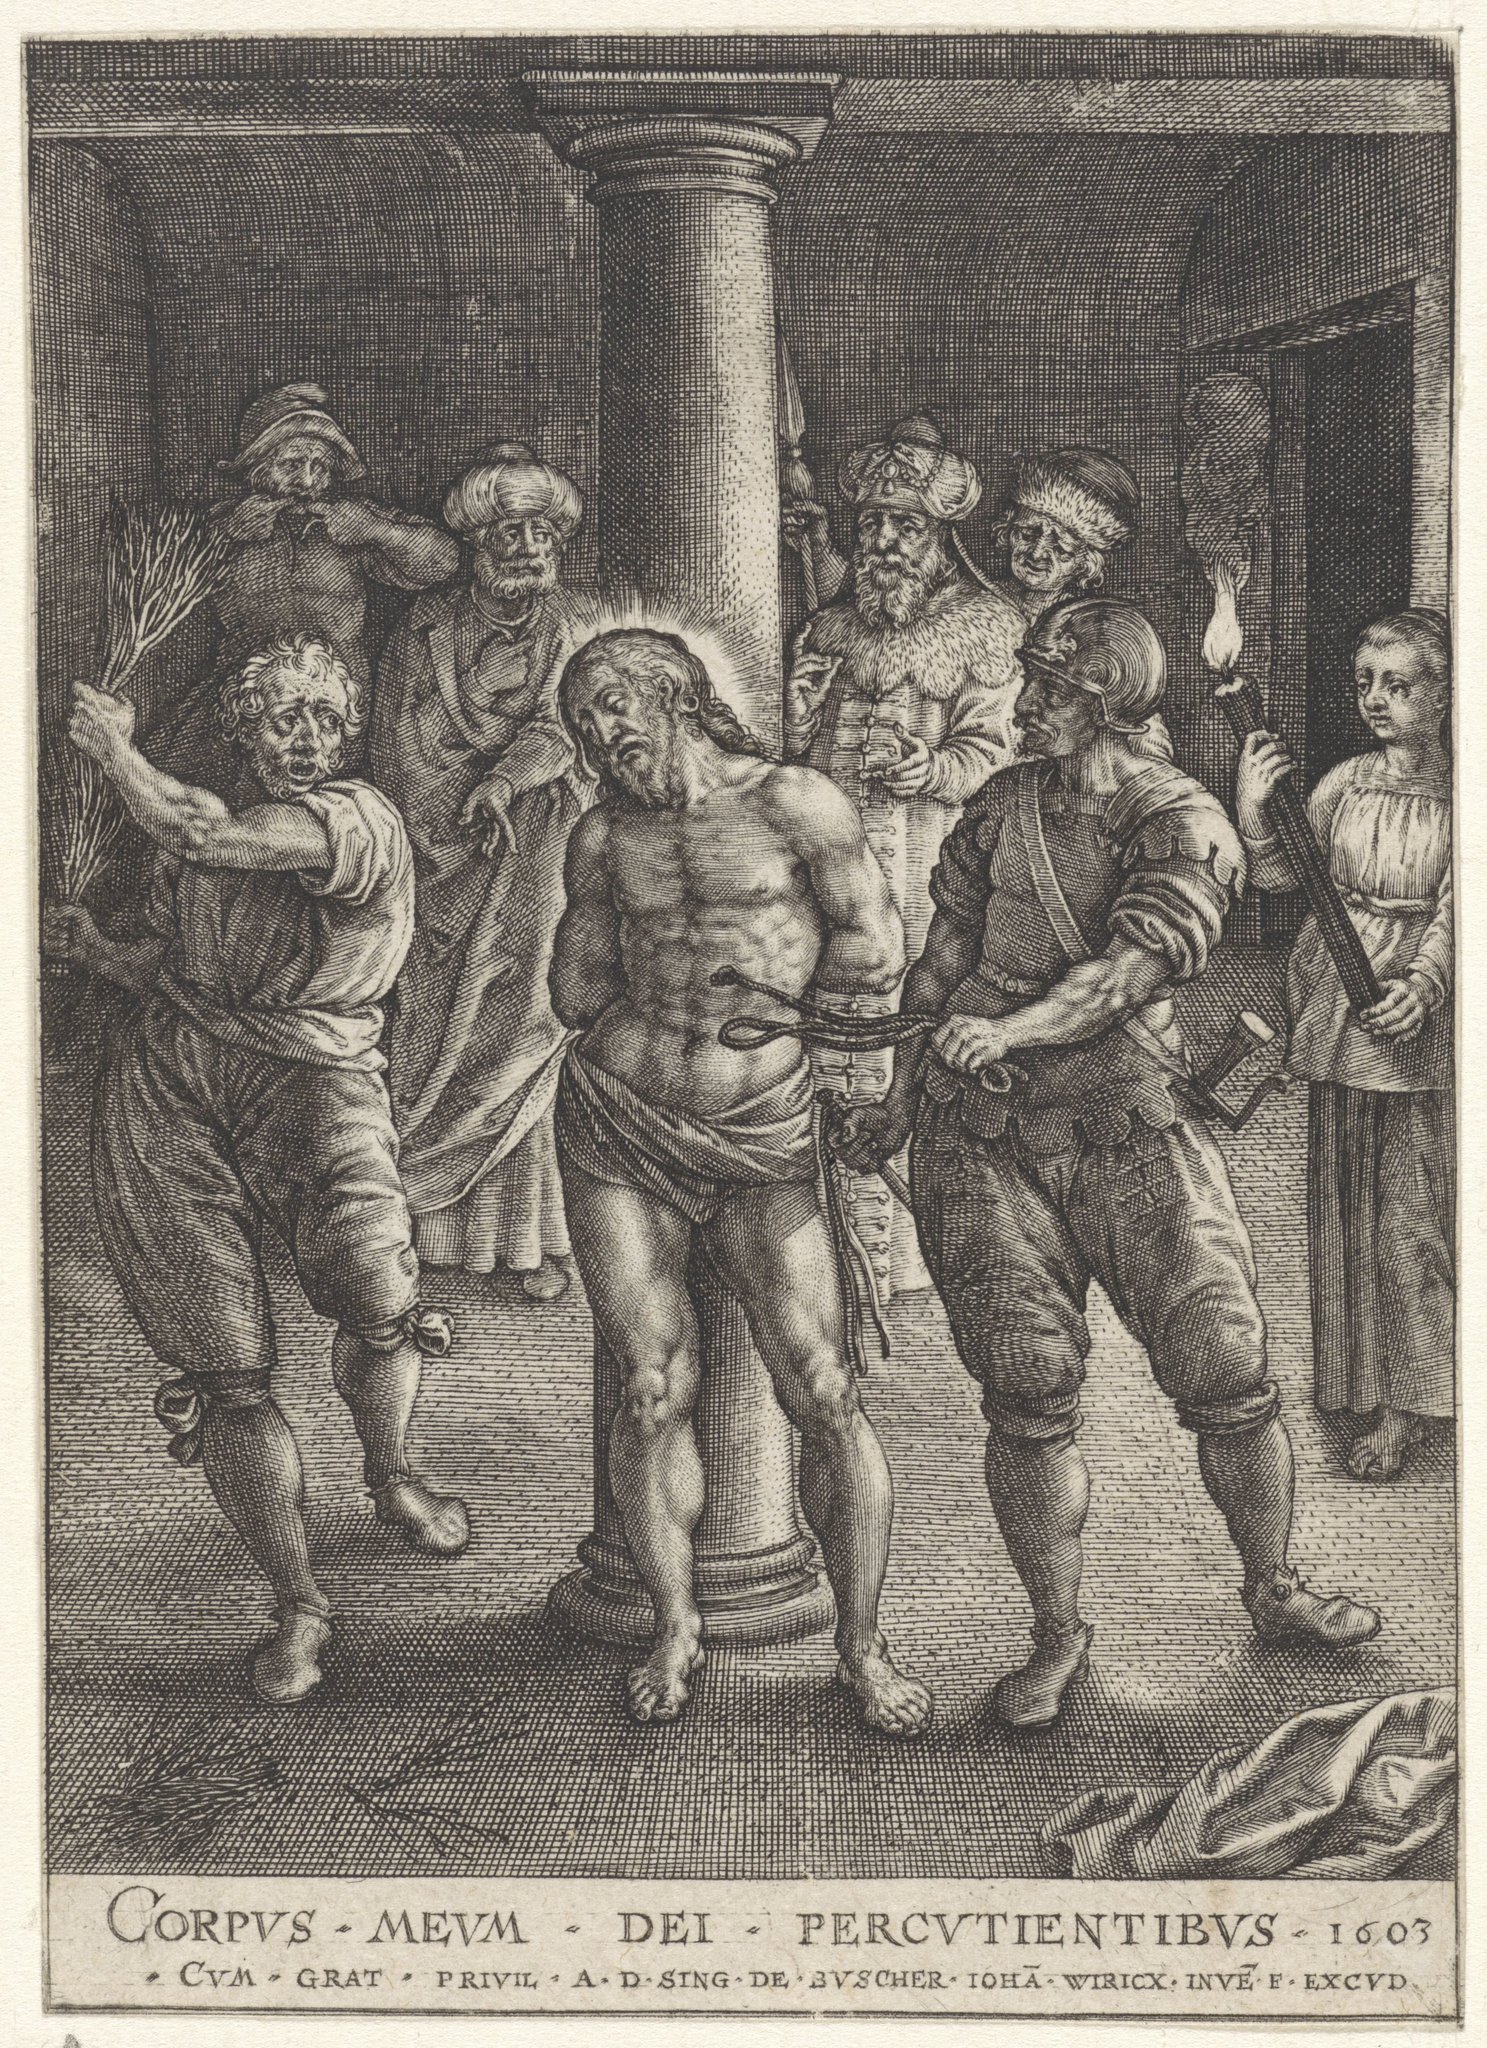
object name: print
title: Corpvs - mevm - dei - percvtientibvs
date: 1603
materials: paper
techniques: engraving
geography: antwerp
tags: flagellation by soldiers, christ usually tied to a column (matthew 27:26; mark 15:15; john 19:1)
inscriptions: collector's mark: Lugt 2228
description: Christus, vastgebonden aan een pilaar, wordt door soldaten gegeseld. Op de achtergrond toeschouwers, onder wie Pilatus.